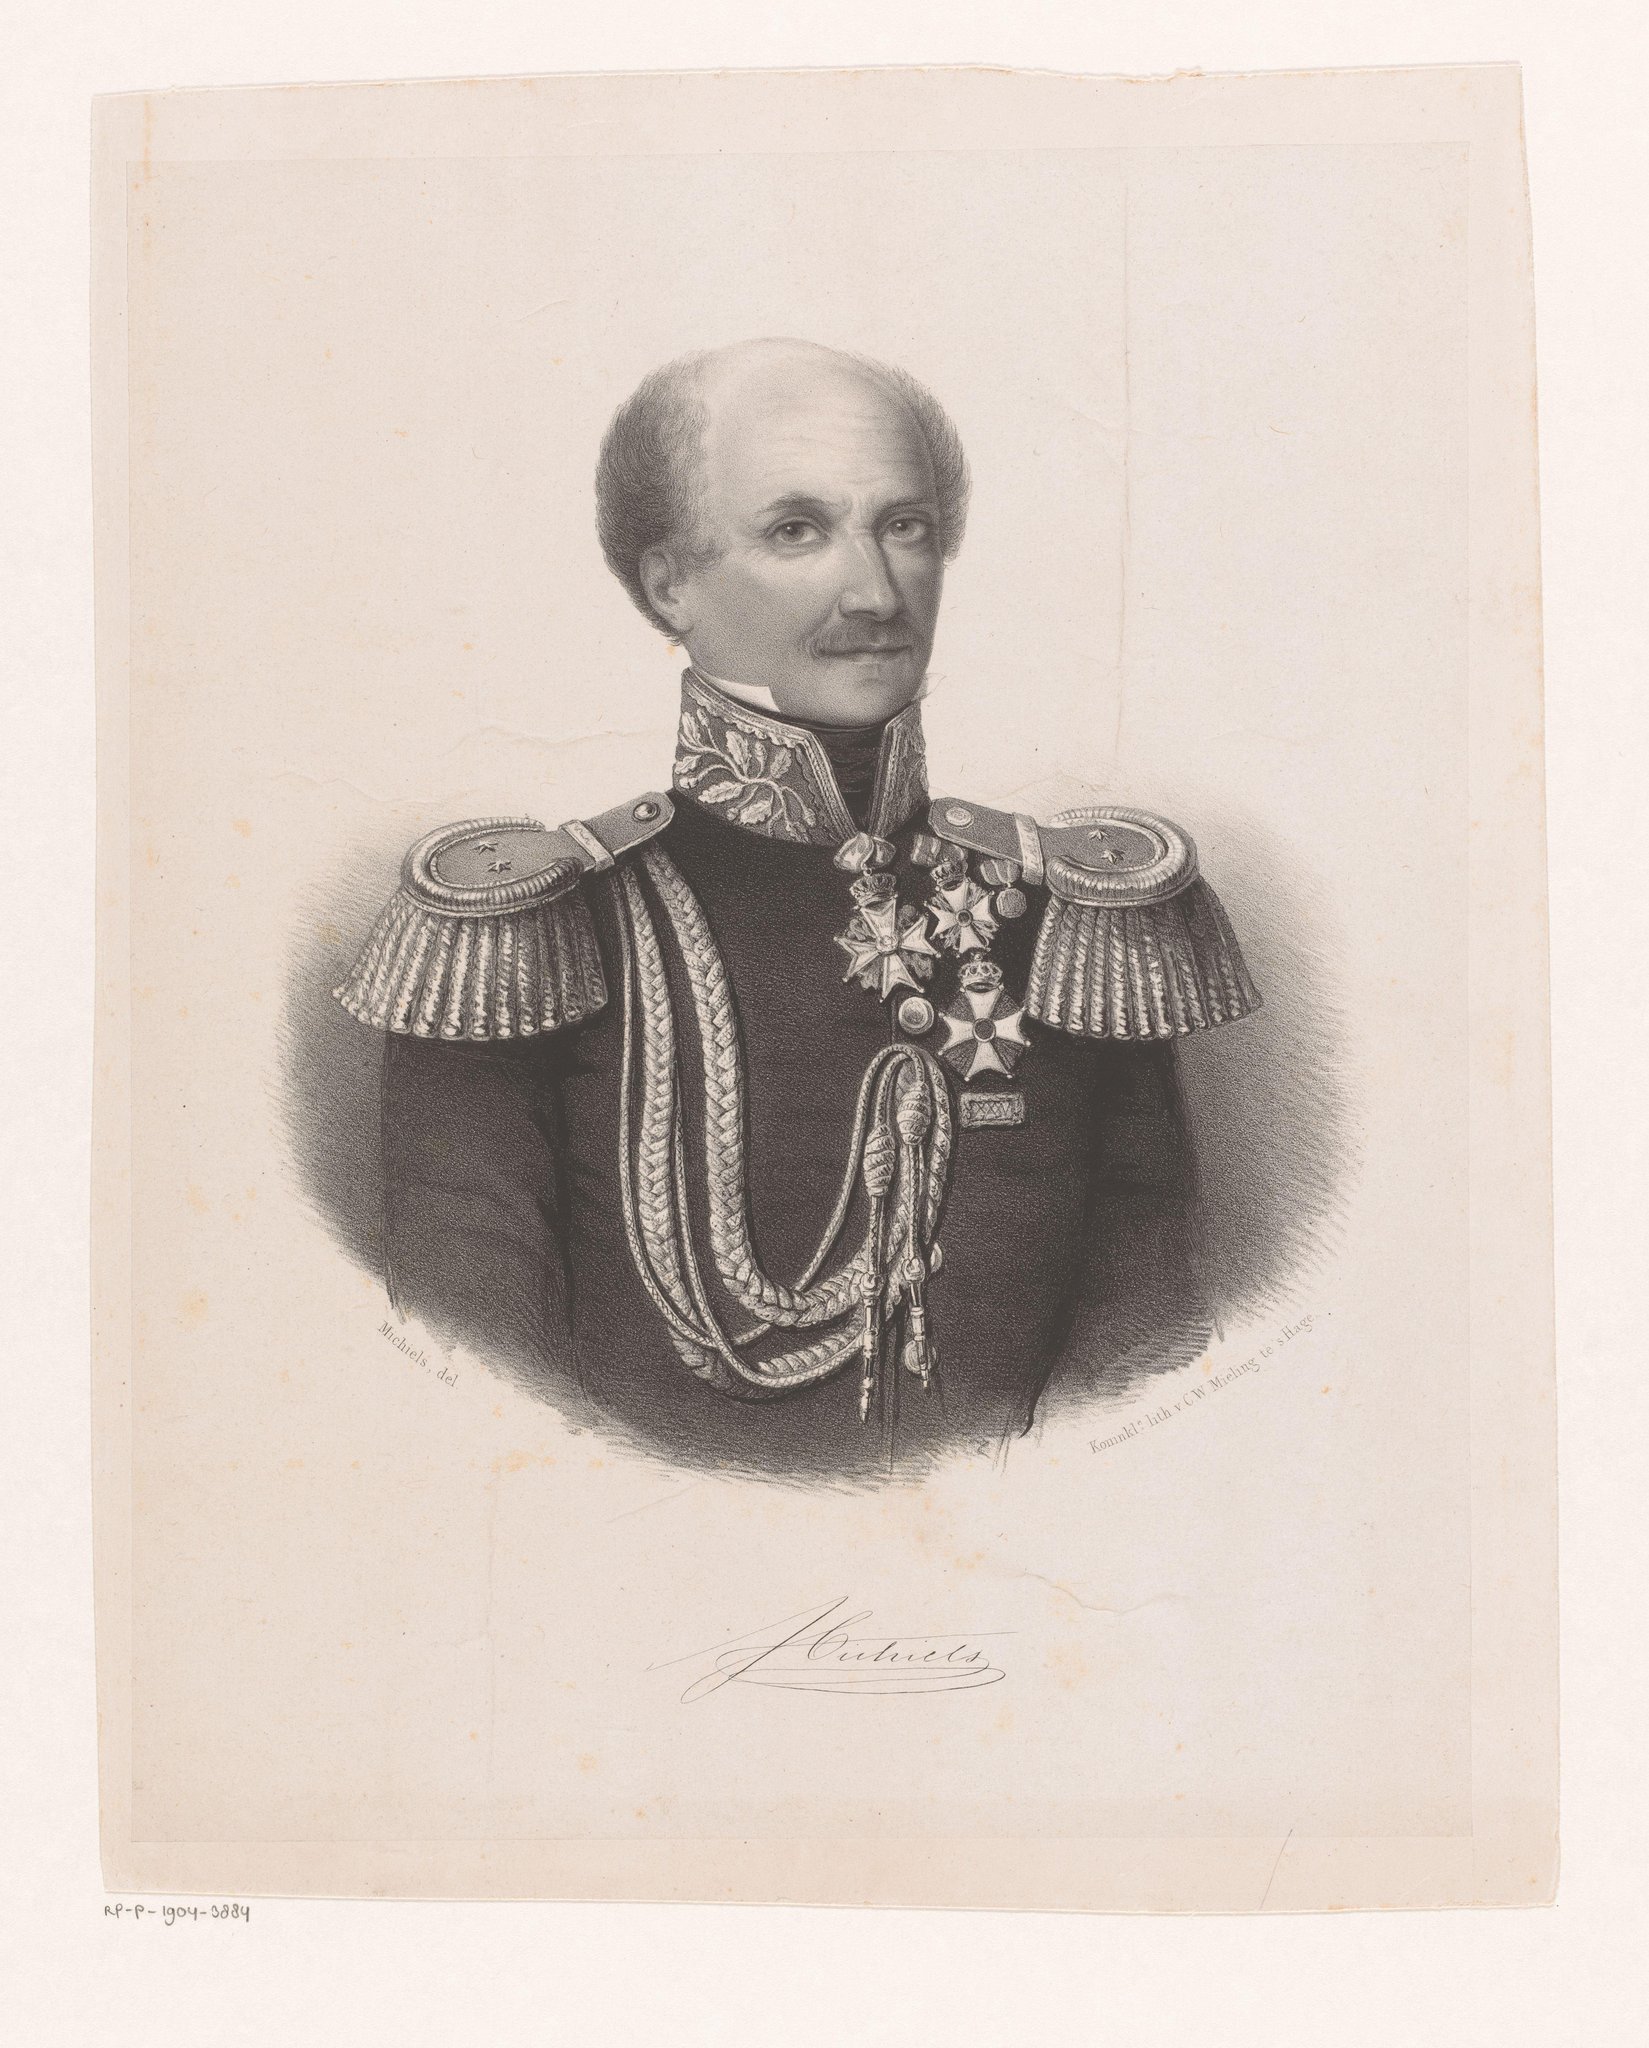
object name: print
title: Portret van Andreas Victor Michiels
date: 1847-1865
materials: paper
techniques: lithograph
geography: the hague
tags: maastricht, knighthood order, historical persons (+ (full) bust portrait)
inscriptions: collector's mark: Lugt 2228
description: De geportretteerde draagt een militair uniform met epauletten en ridderorden.